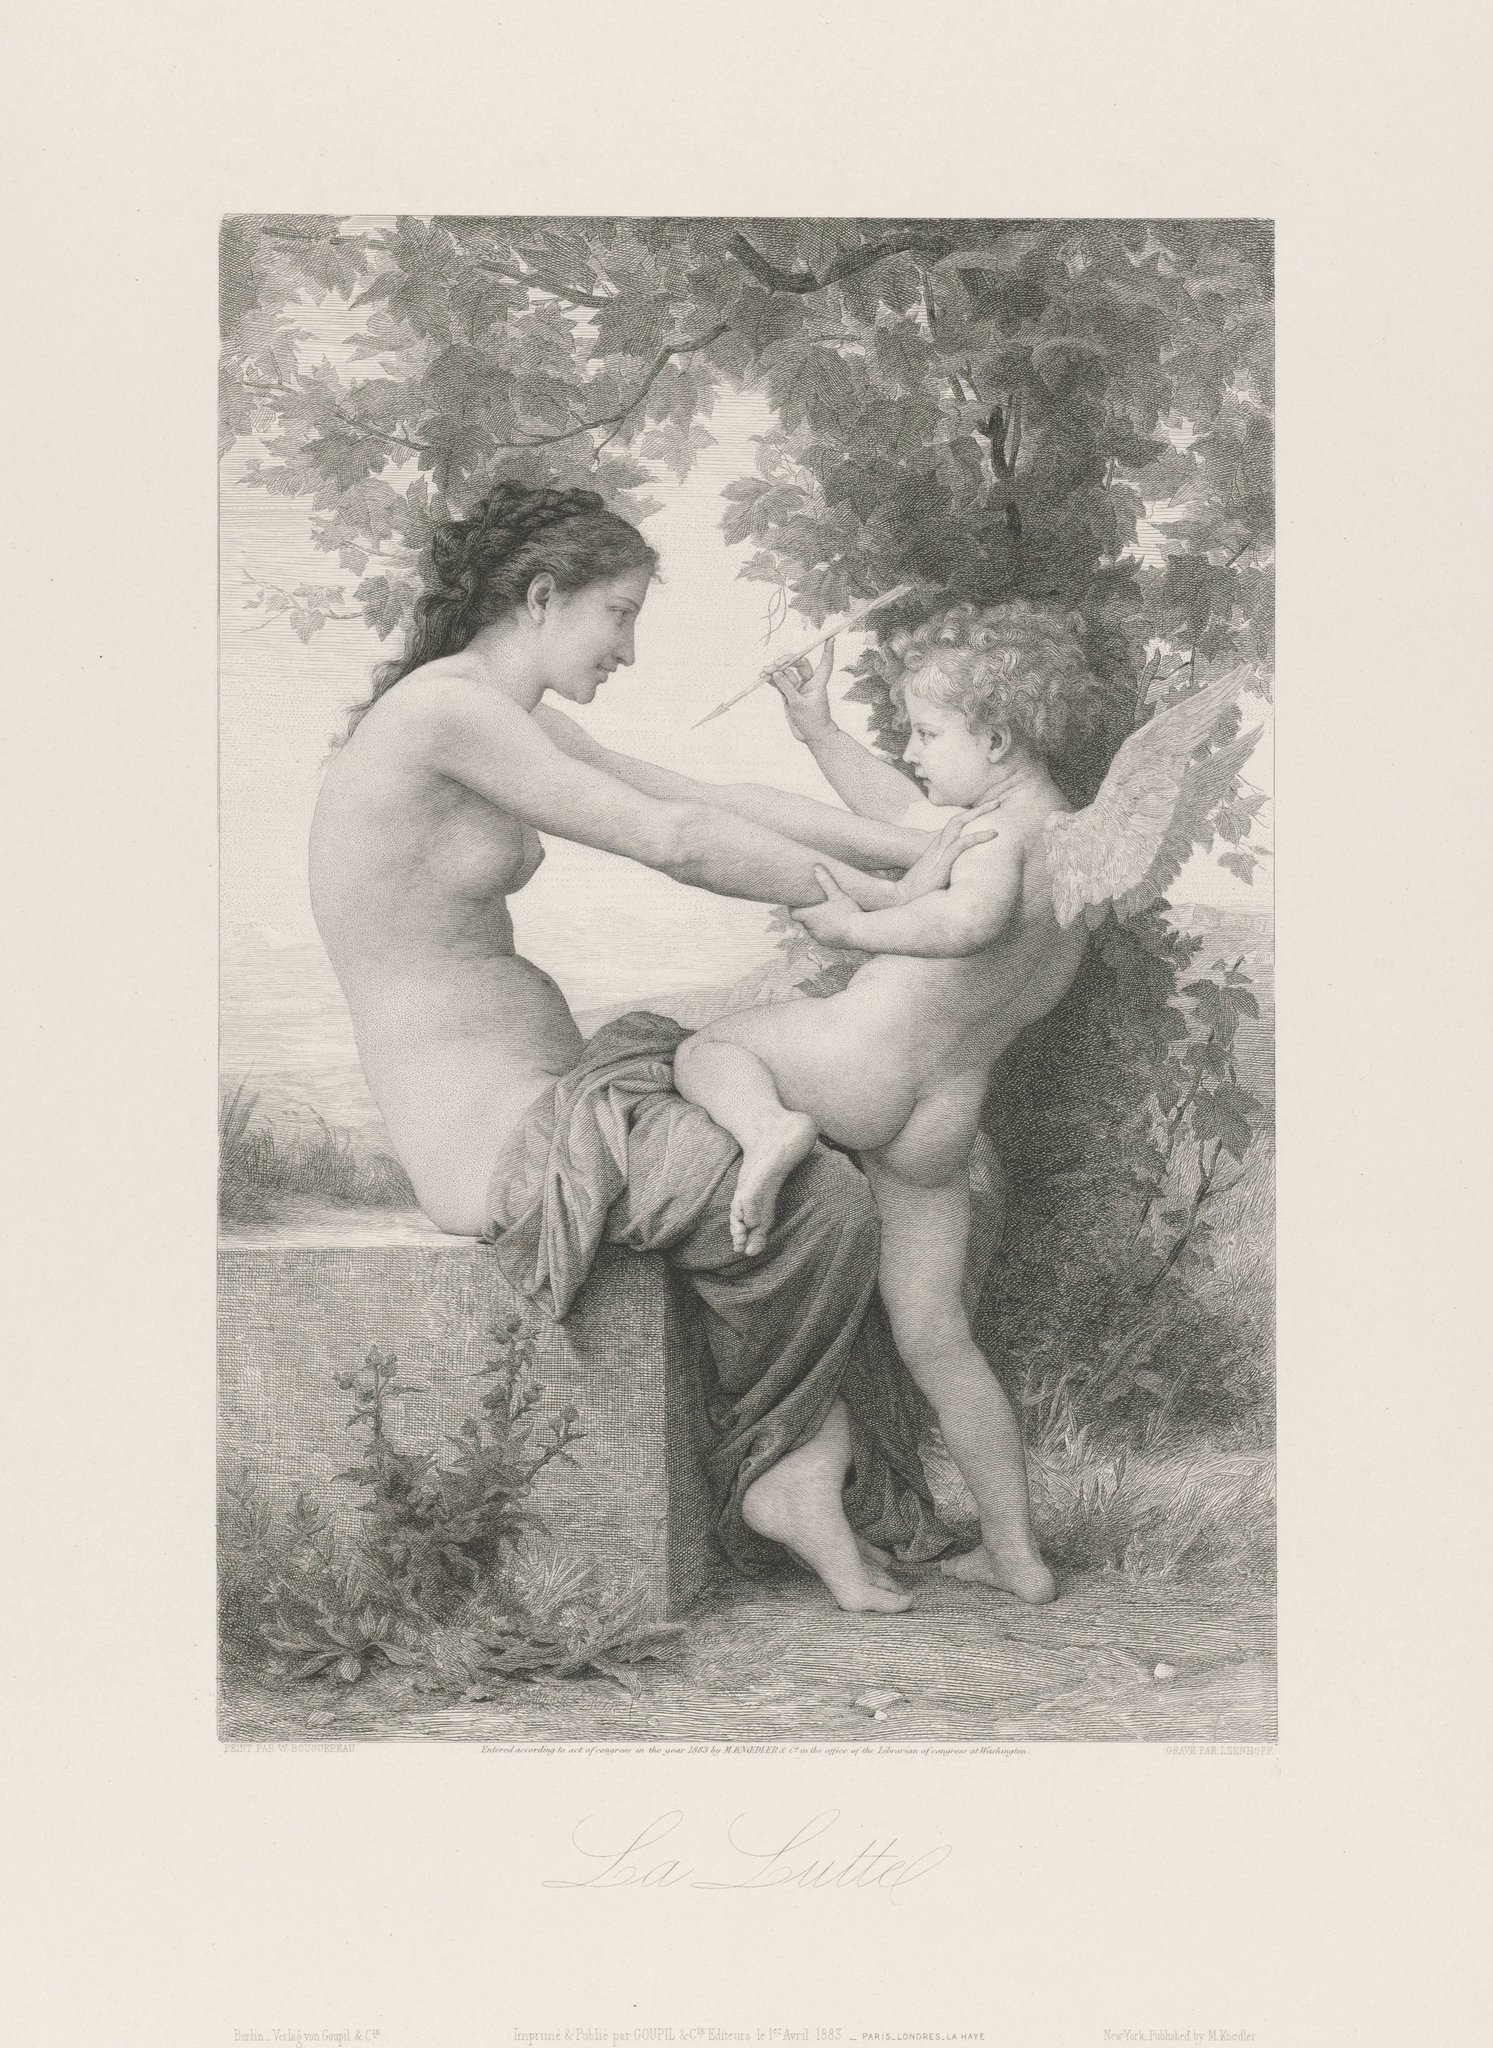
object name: print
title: Amor en Psyche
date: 1883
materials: paper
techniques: etching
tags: story of cupid and psyche (apuleius, 'metamorphoses' (golden ass) iv 28 - vi 25)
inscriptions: collector's mark: Lugt 2228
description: Psyche zit onder een boom op een stenen bank en duwt Amor van zich af.